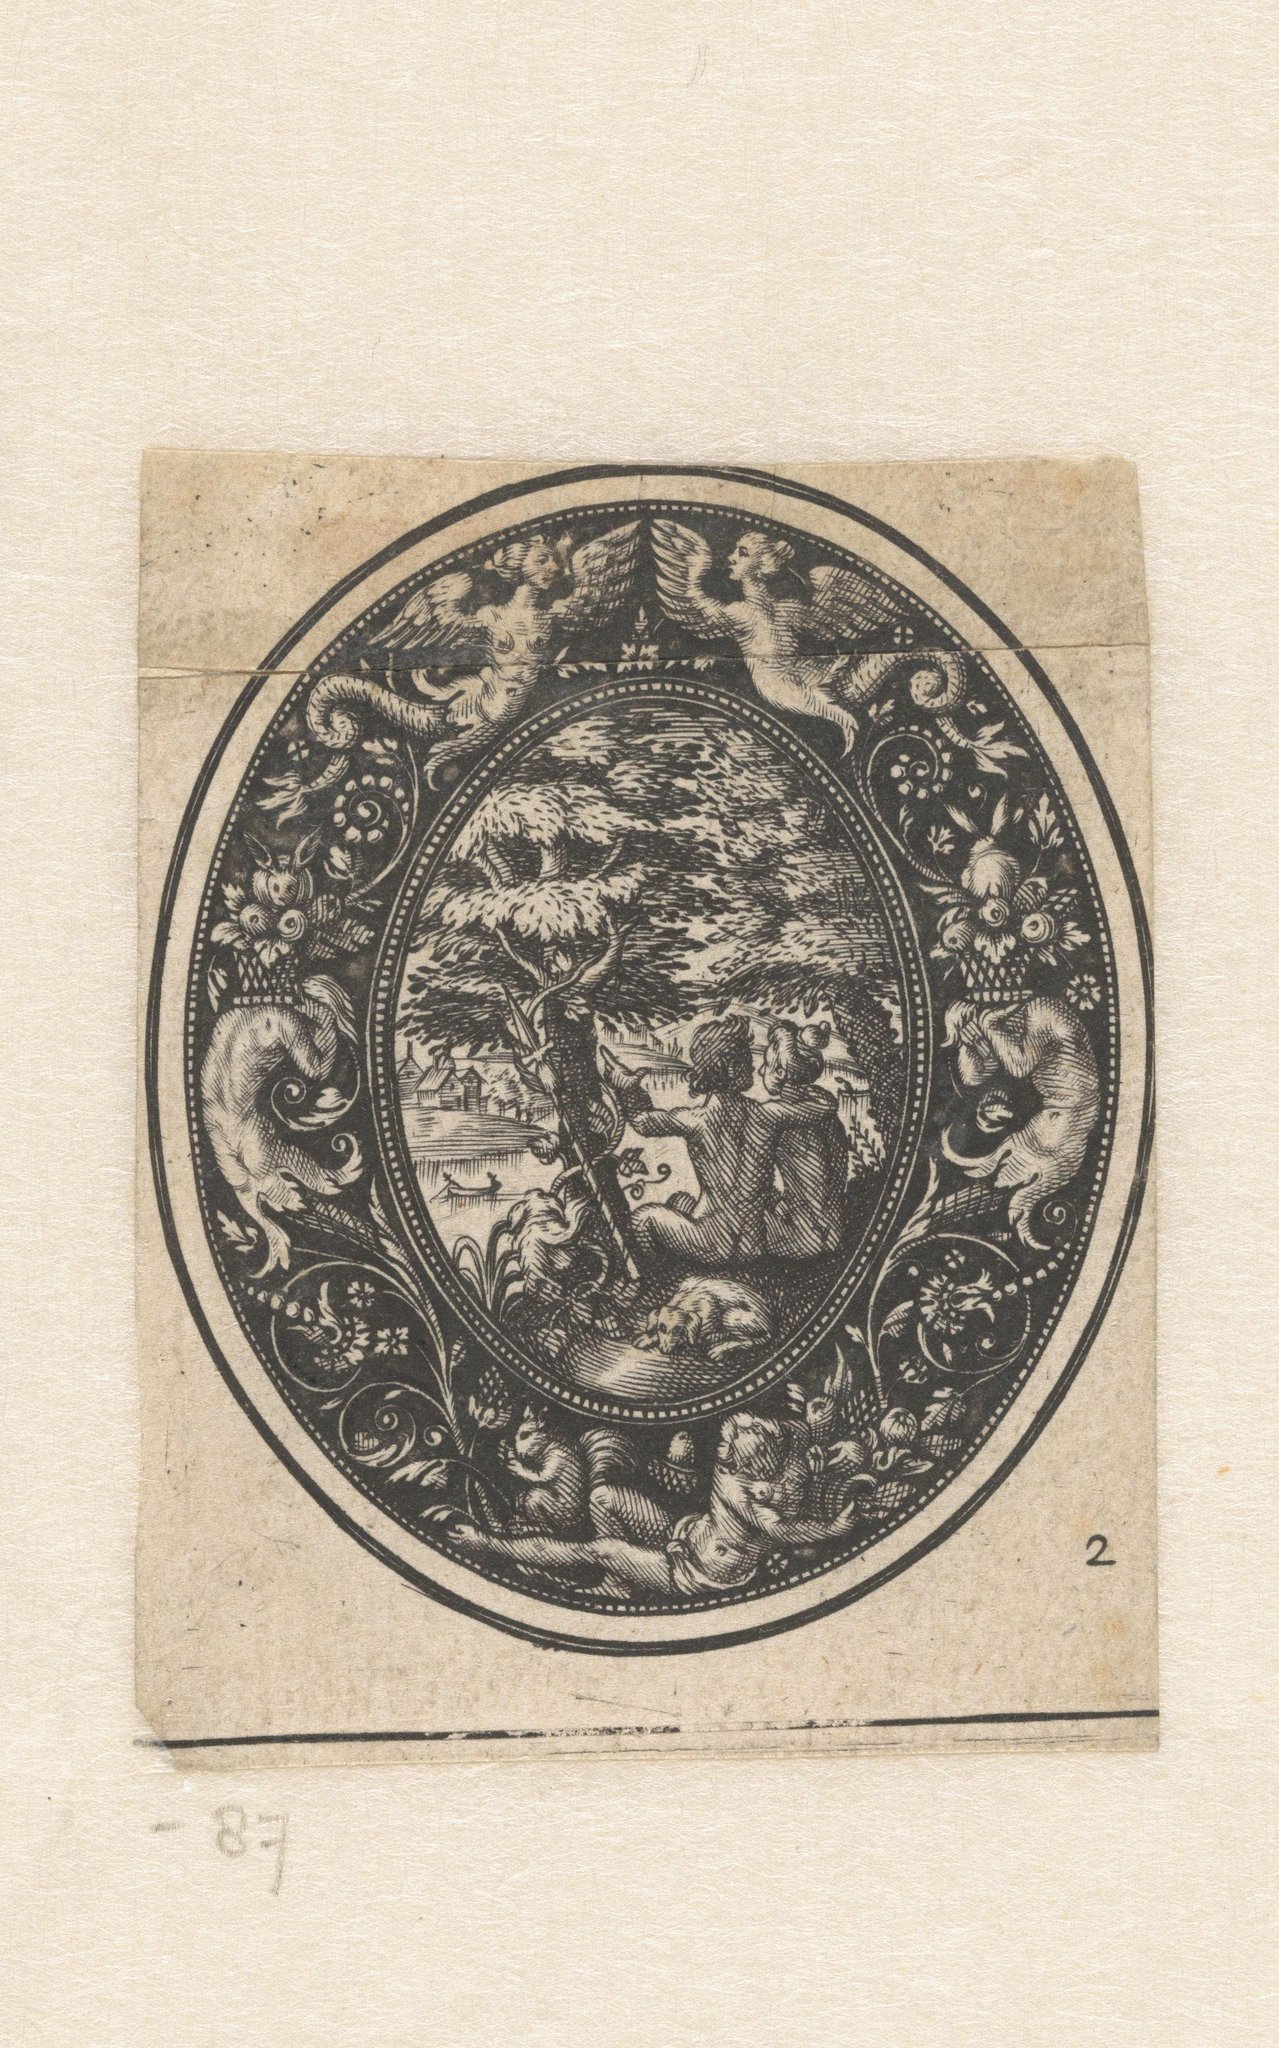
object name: print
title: Ovaal medaillon met Adonis en Venus onder een boom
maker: antoine jacquard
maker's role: print maker, publisher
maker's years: -1640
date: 1610-1615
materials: paper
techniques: etching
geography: paris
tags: ornaments ~ art, foliage ~ ornament, ornament ~ medallion, tales and fairy tales (with title), couple of lovers, venus and adonis as lovers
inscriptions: collector's mark: Lugt 2228, number: ‘2’, collector's mark: Lugt 2760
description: Ontwerp voor een horlogekast in de vorm van een ovaal medaillon met ornamentele rand versierd met gestileerde bladeren en melusina, in het midden een scène van een naakt stel zittend onder een boom, de man (Adonis) heeft zijn arm om de vrouw (Venus) geslagen en wijst met zijn andere arm in de verte, achter hen een liggende hond.